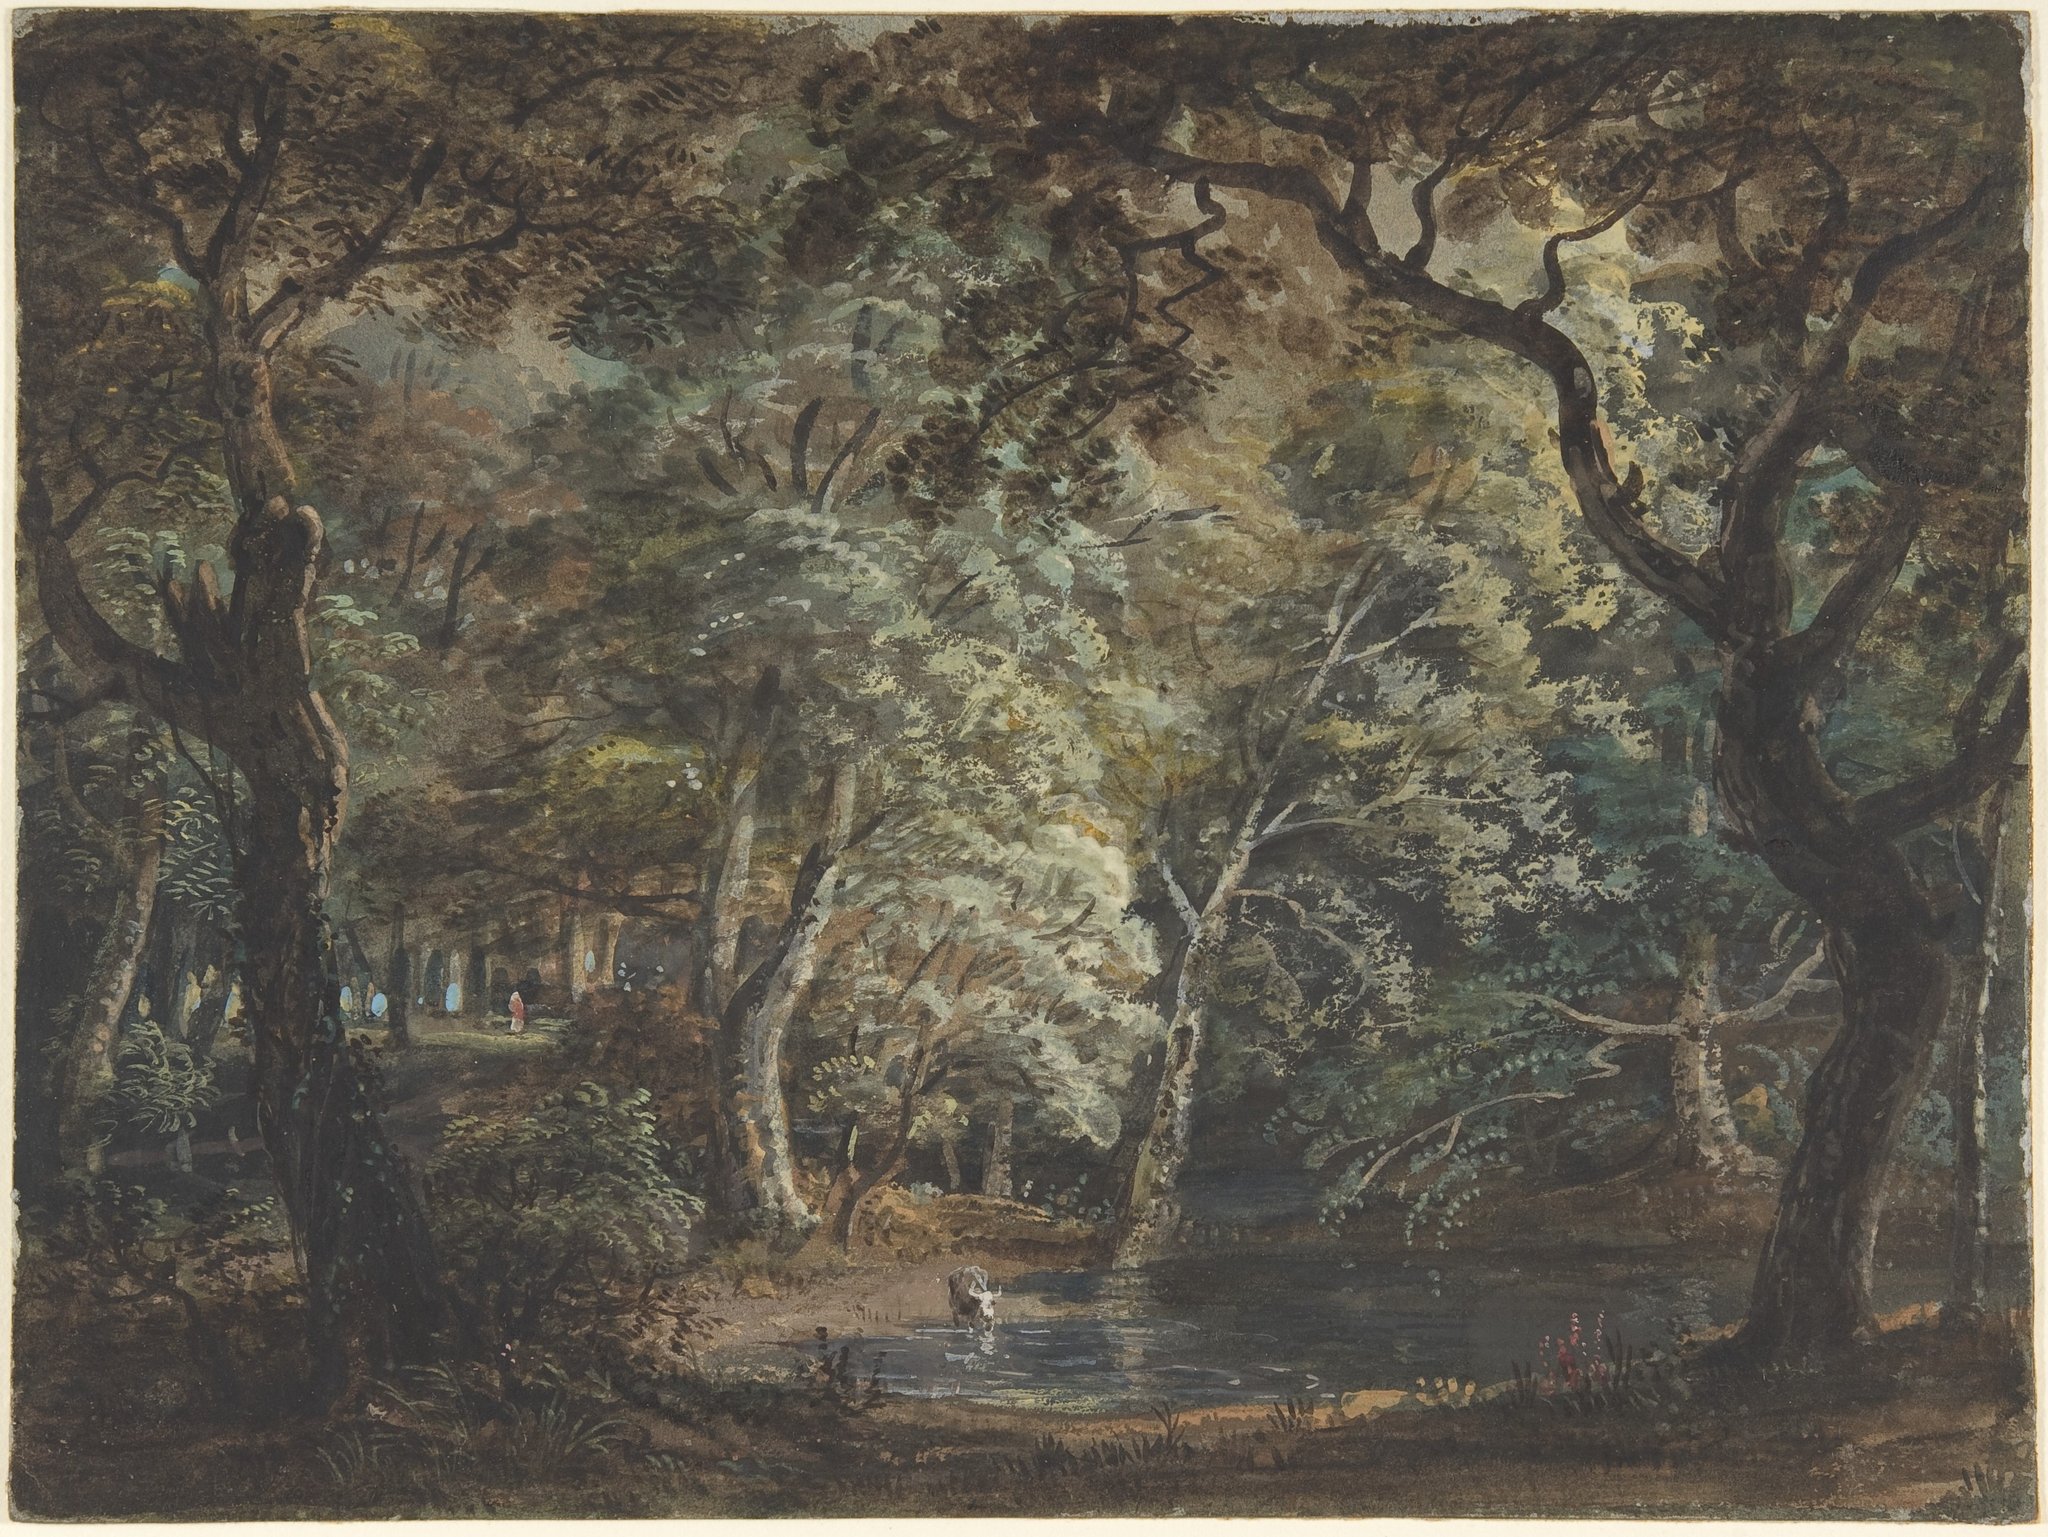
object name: drawing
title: Windsor Great Park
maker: paul sandby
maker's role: artist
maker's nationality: british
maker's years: 1731-1809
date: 1790-1799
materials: gouache, gum arabic, watercolor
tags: parks,bulls,ponds,forests